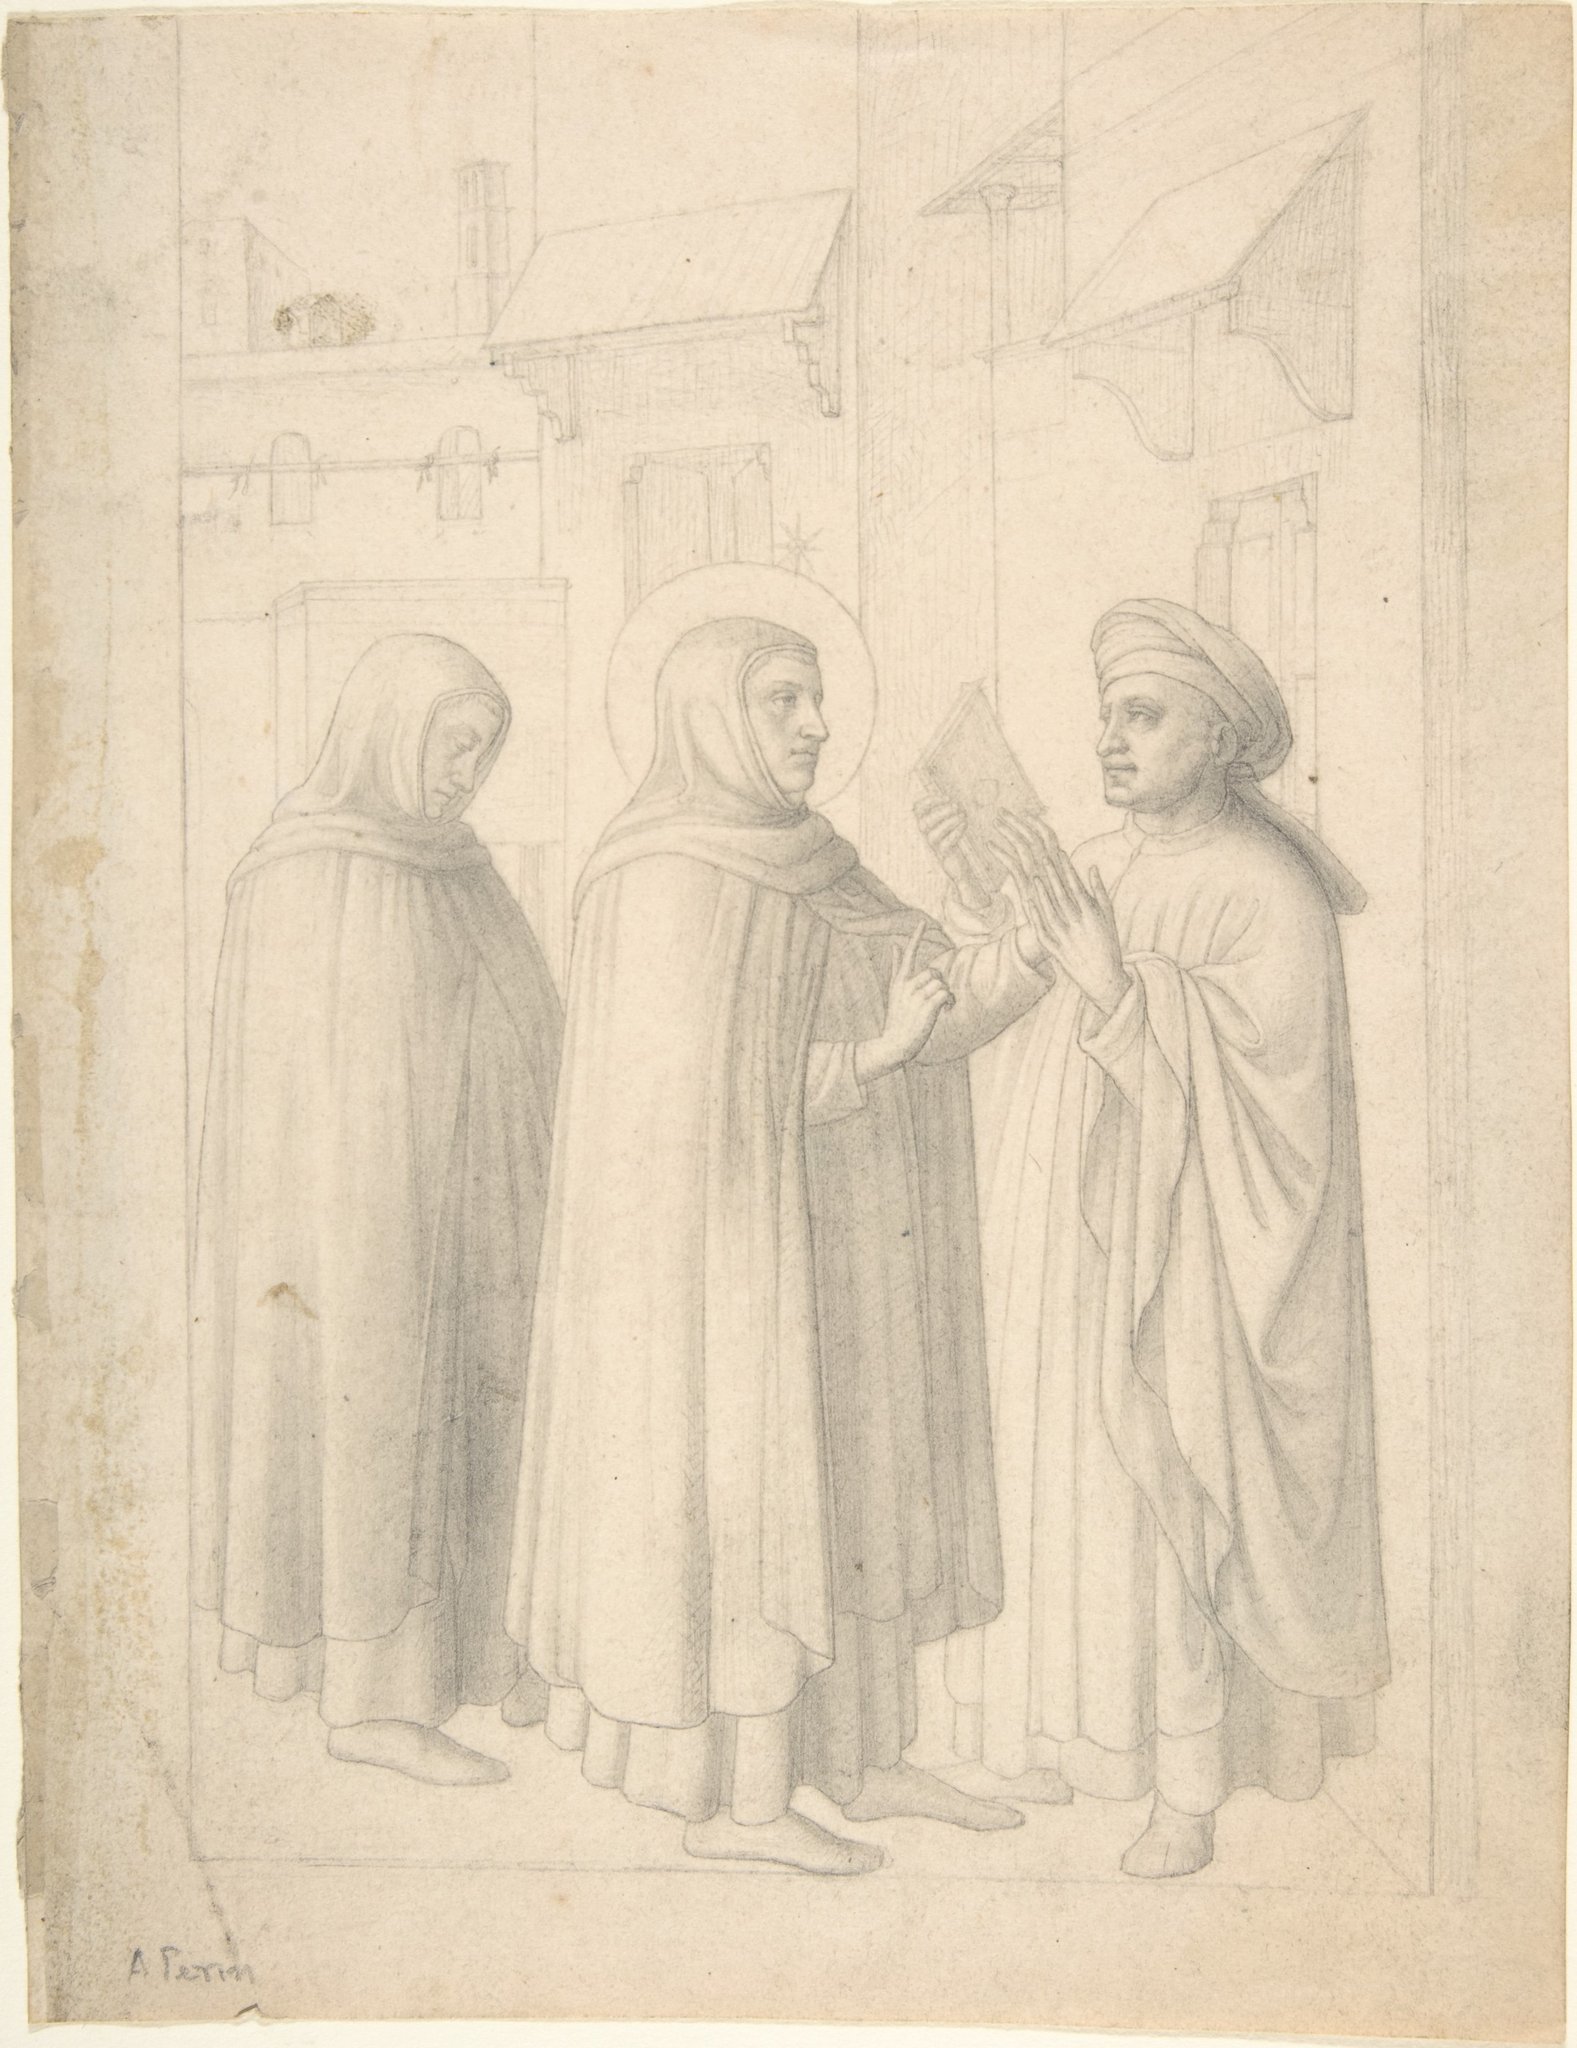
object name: drawing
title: Scene with a Saint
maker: anonymous, italian, 19th century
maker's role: artist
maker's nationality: italian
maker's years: 1800-1900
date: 1800-1900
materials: graphite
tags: books,men,women,saints